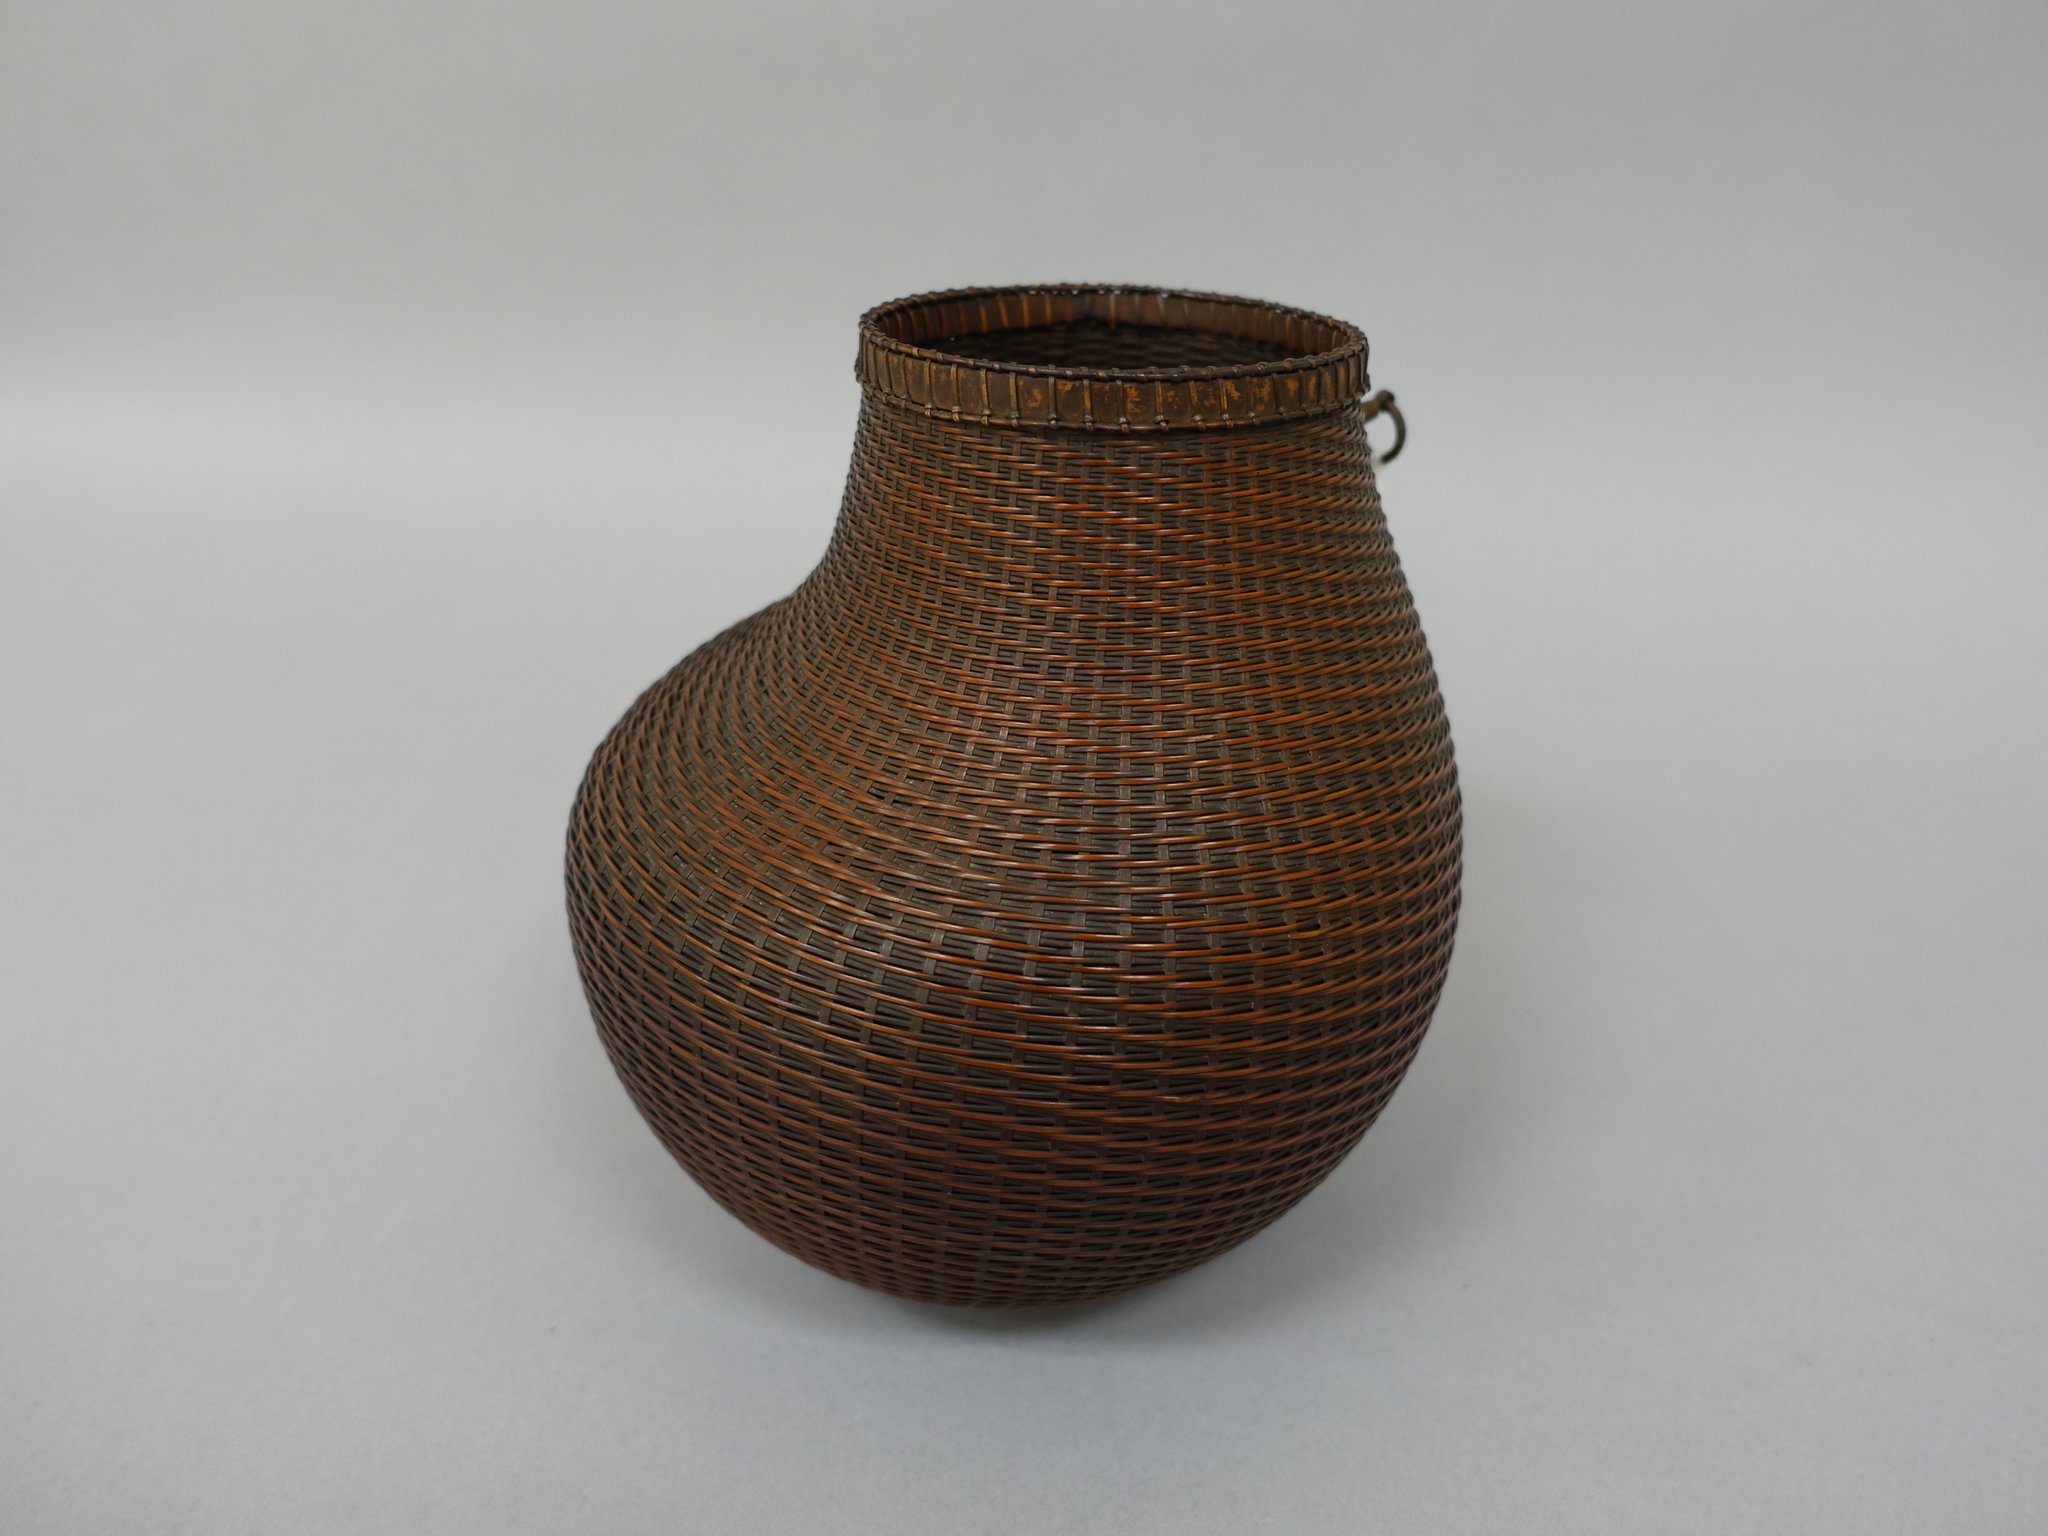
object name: basket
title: Gourd-Shaped Basket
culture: japanese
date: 1801-1900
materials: bamboo